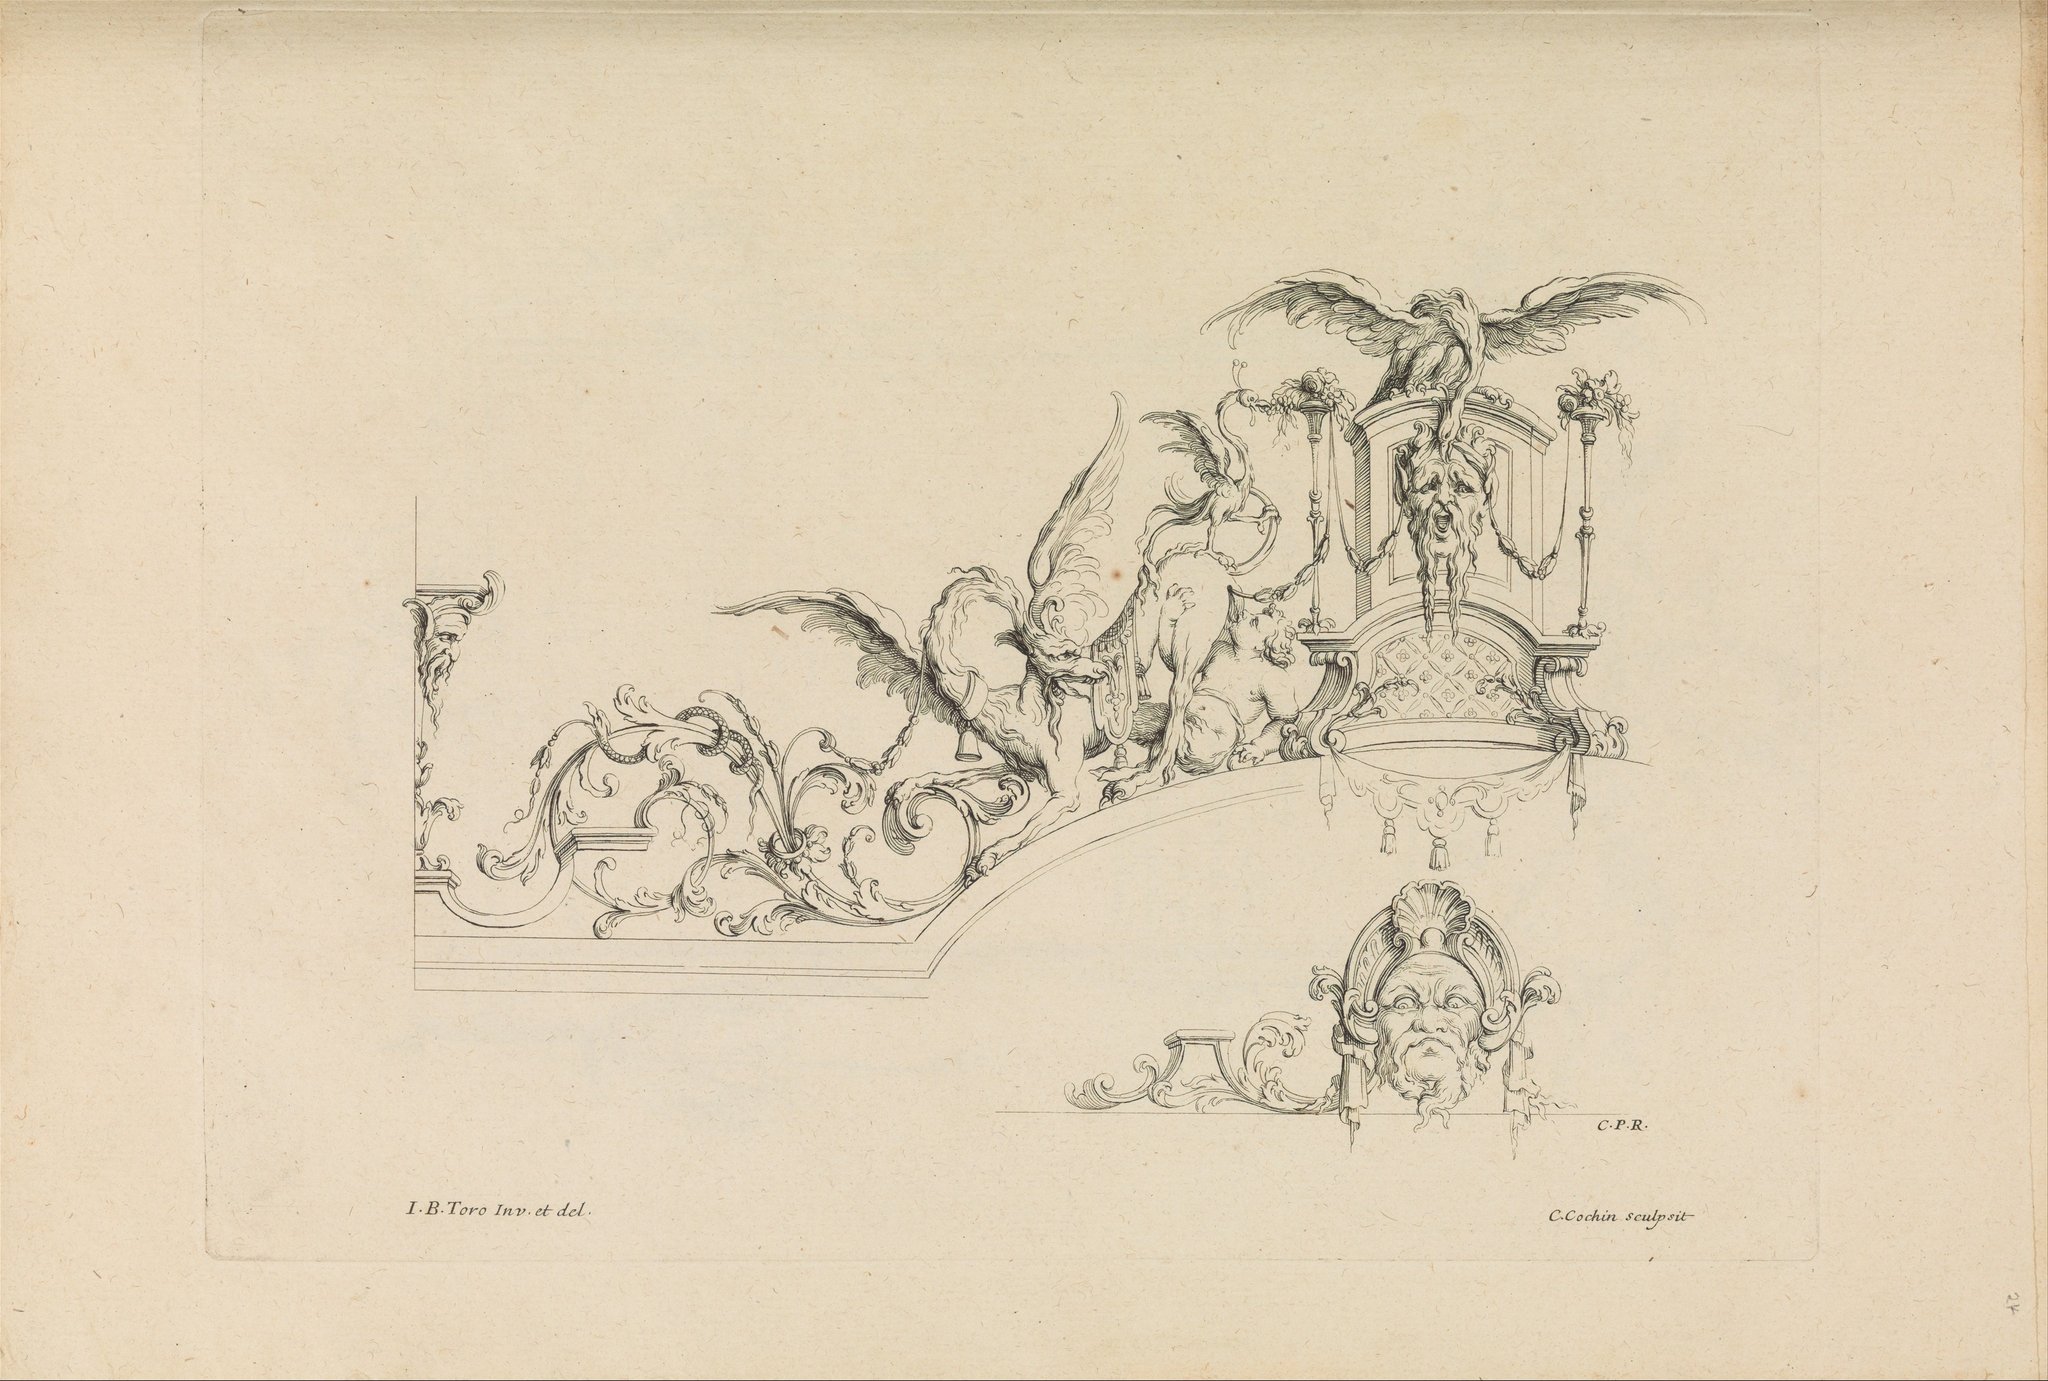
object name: album print ornament architecture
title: Desseins Arabesques a Plusieurs Usages Inventés par J.B. Toro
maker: jean bernard toro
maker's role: designer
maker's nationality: french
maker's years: 1672-1731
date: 1716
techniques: etching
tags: birds,grotesques,ornament,mythical creatures